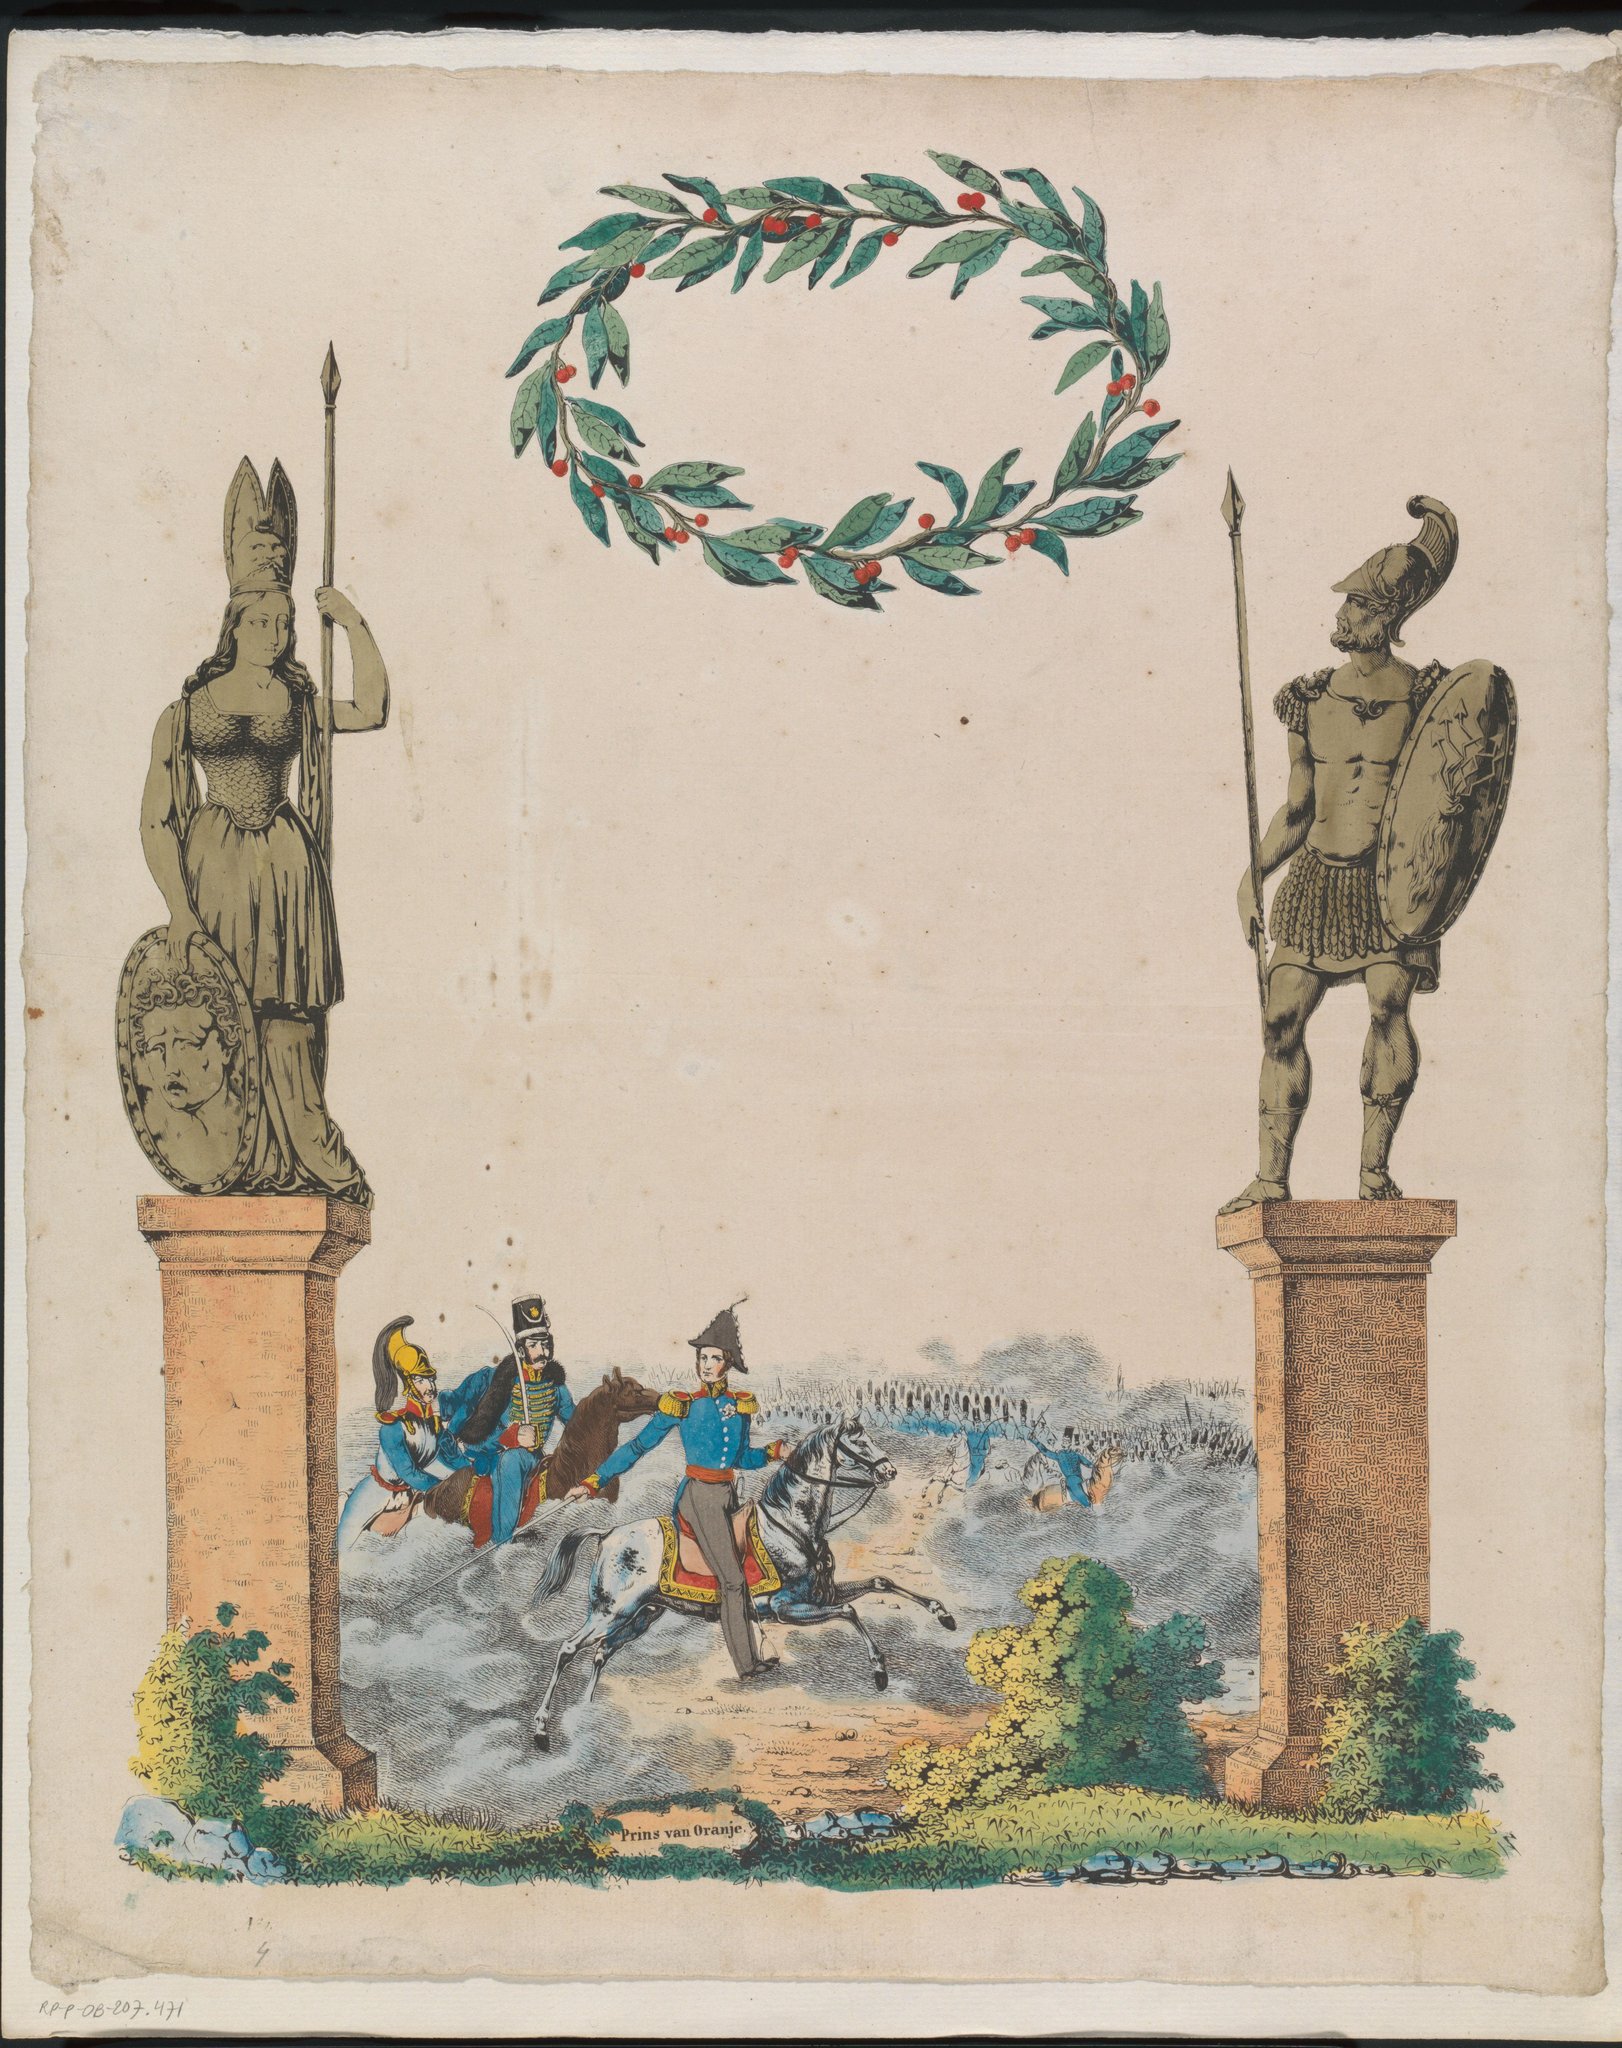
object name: print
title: Wensbrief met de prins van Oranje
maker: Anonymous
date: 1780-1899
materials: paper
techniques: colour, lithograph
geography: netherlands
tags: riding a horse, ass, or mule; rider, horseman, prince, warfare; military affairs (+ cavalry, horsemen), piece of sculpture, reproduction of a piece of sculpture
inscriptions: collector's mark: Lugt 2760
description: Wensbrief met onbeschreven cartouche binnen een decoratief kader met een voorstelling van een prins van Oranje te paard, met achter hem een leger. Genummerd linksonder: No. 4.